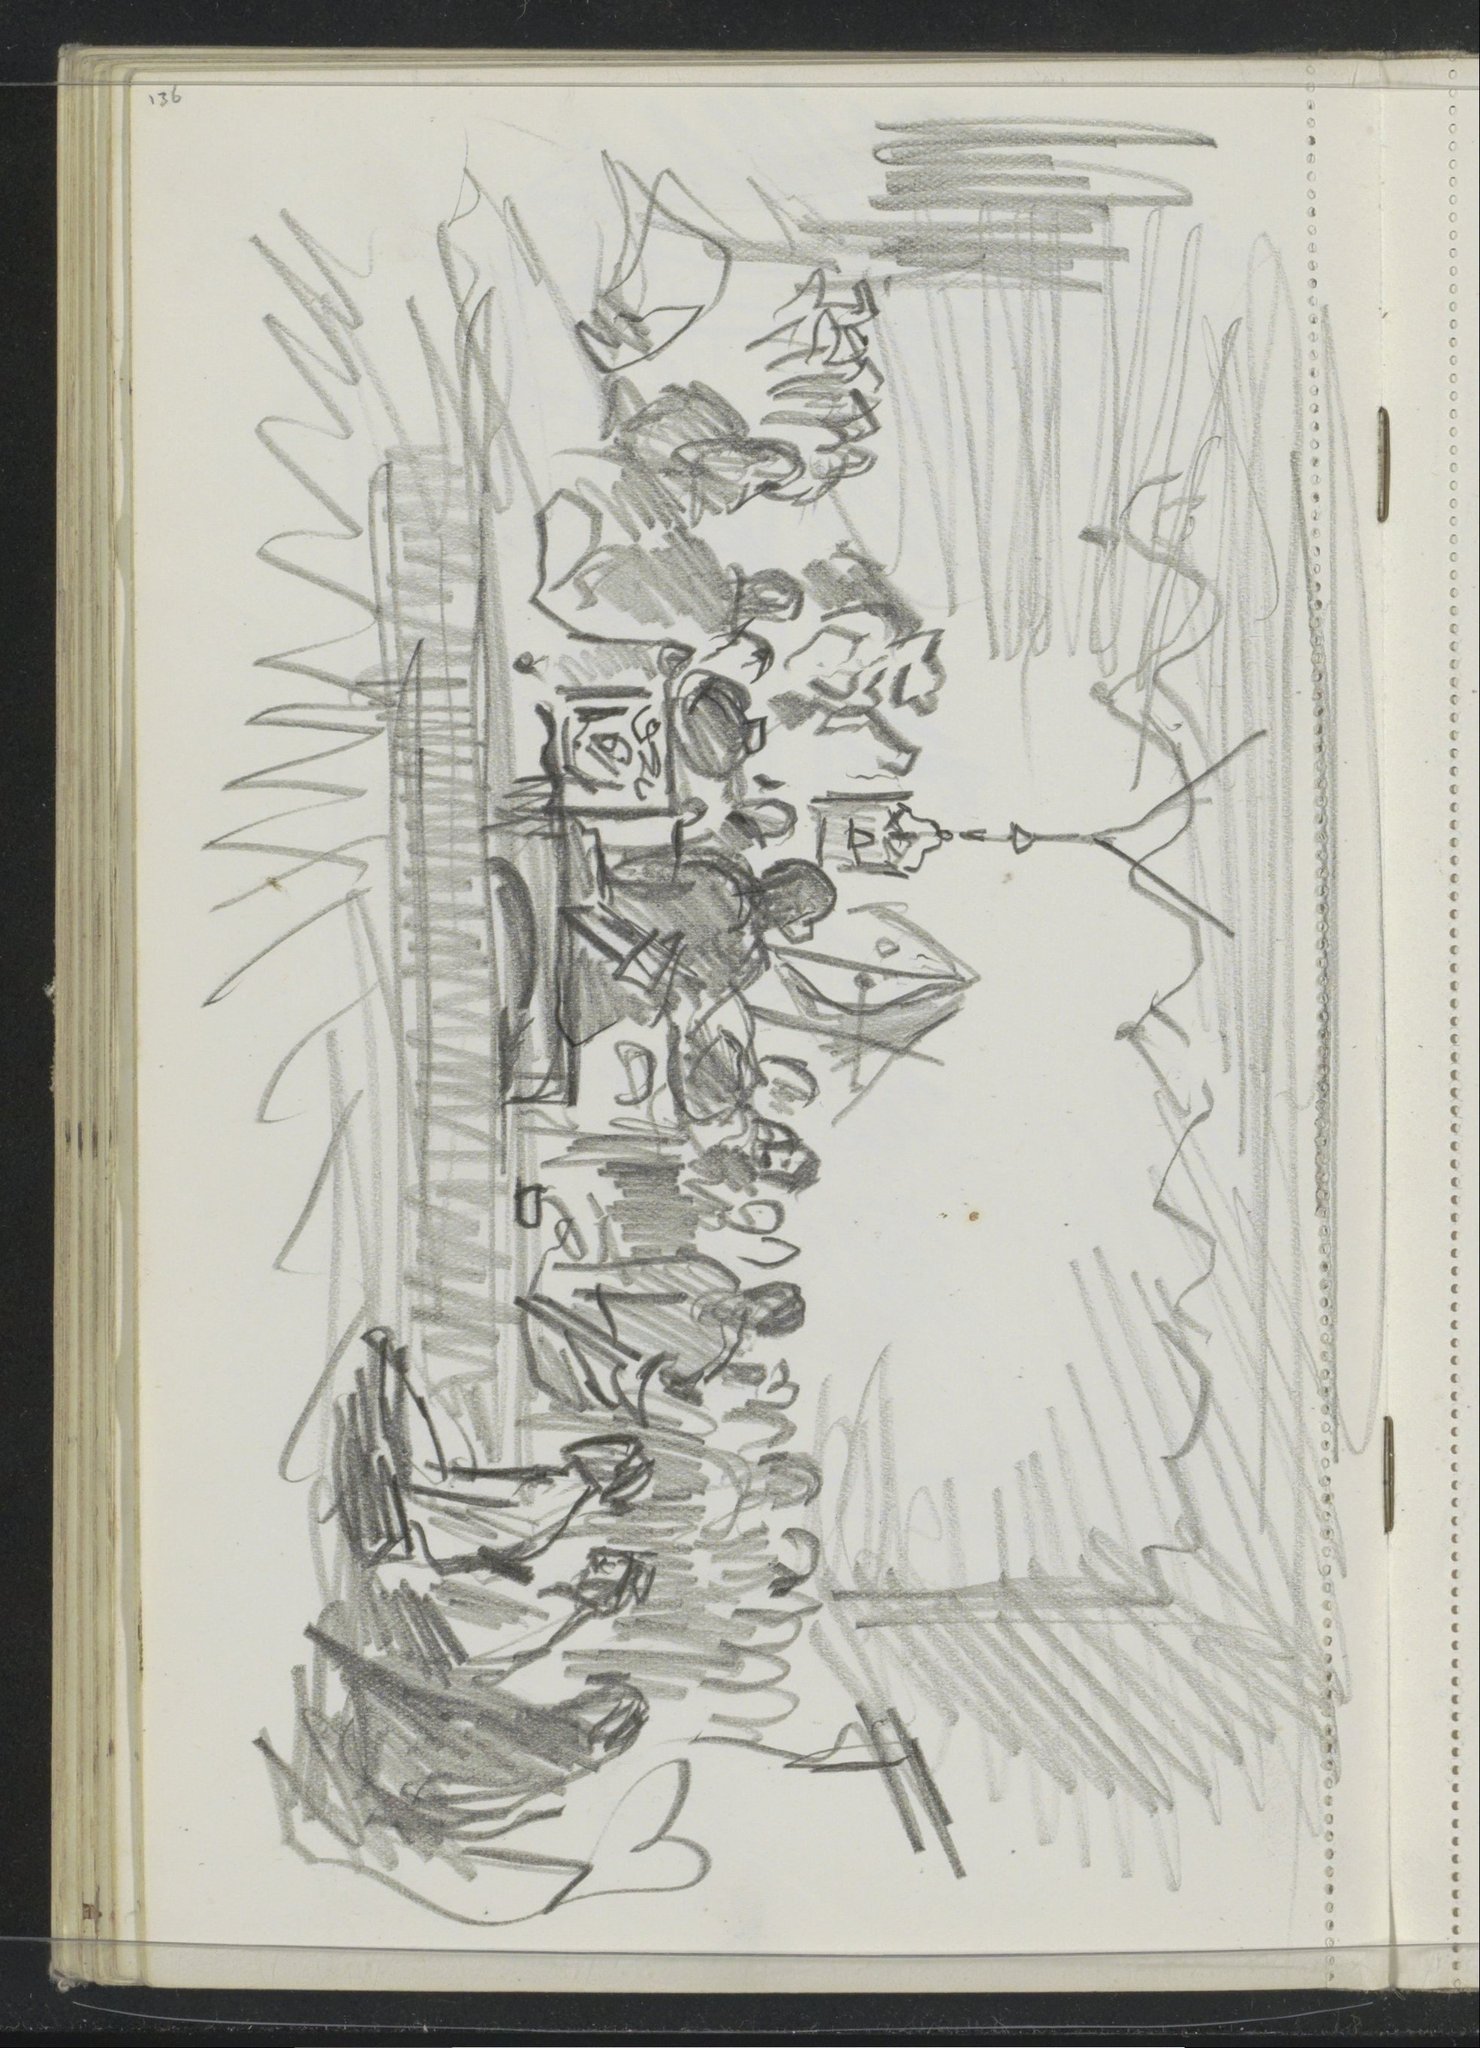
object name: sketchbook leaf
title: Zittende figuren op een overdekte verhoging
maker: marius bauer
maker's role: draughtsman, print maker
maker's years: 1867-1932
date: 1925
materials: paper, pencil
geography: indonesia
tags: asiatic races and peoples, sitting figure, the audience ~ art performance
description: Mogelijk bekijken de figuren een voorstelling. Pagina 136 uit een schetsboek met 74 bladen.